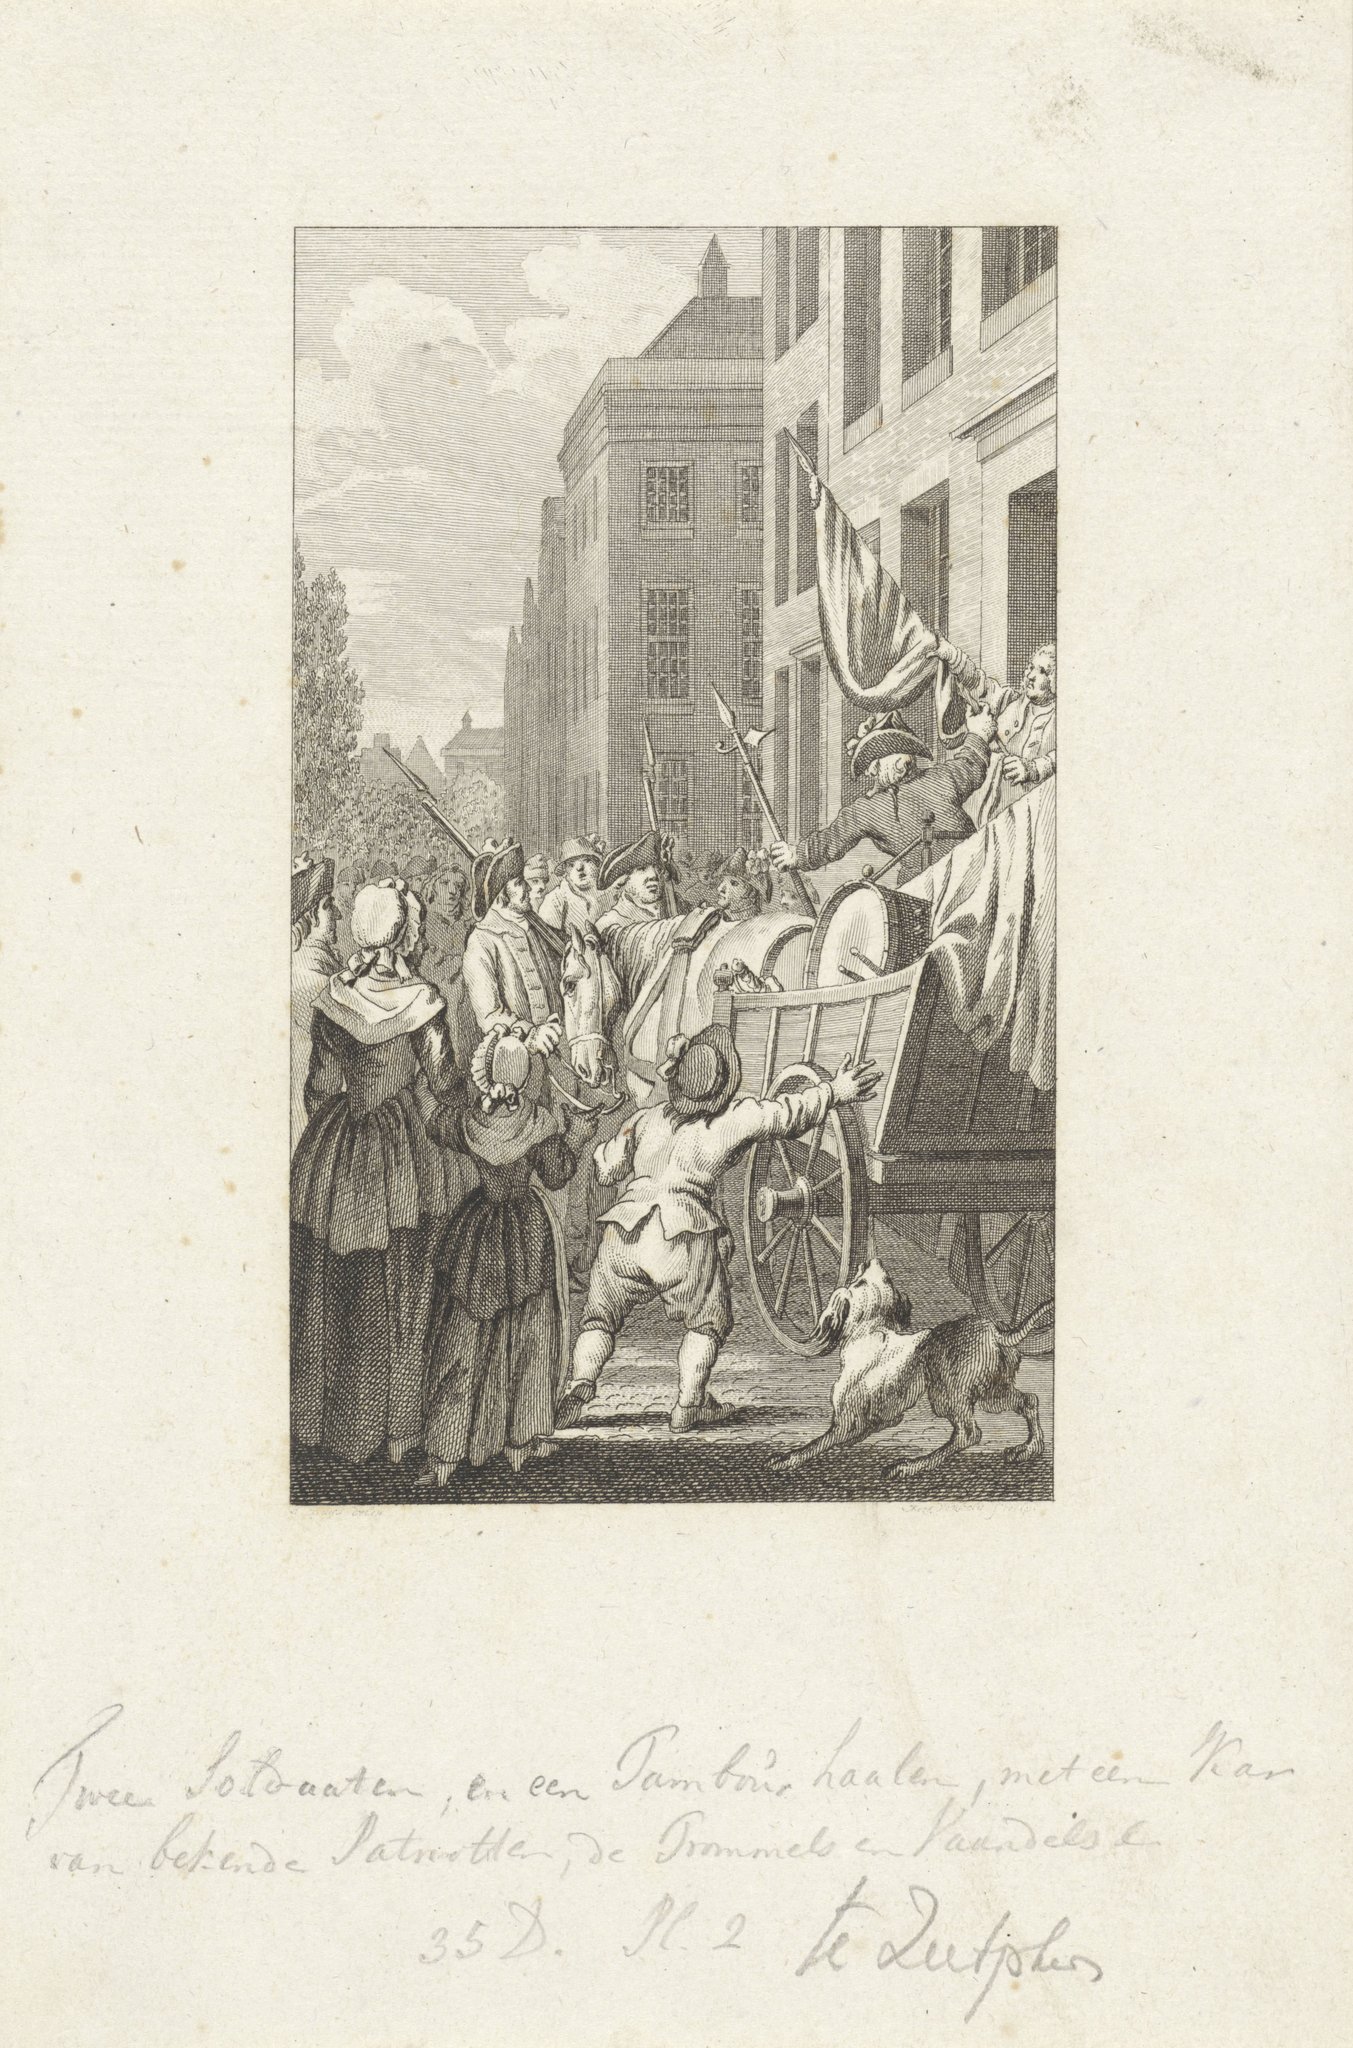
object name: print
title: Afhalen bij patriotten te Zutphen van trommels en vaandels, 1787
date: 1796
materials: paper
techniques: engraving, etching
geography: amsterdam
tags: seizure of goods, patriots (1780-1795)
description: Gebruikt als illustratie in: Kok, Jacobus. Vaderlandsch Woordenboek. Amsterdam: Johannes Allart, 1785-1799, 35 delen, dl. 35, pl. 2.